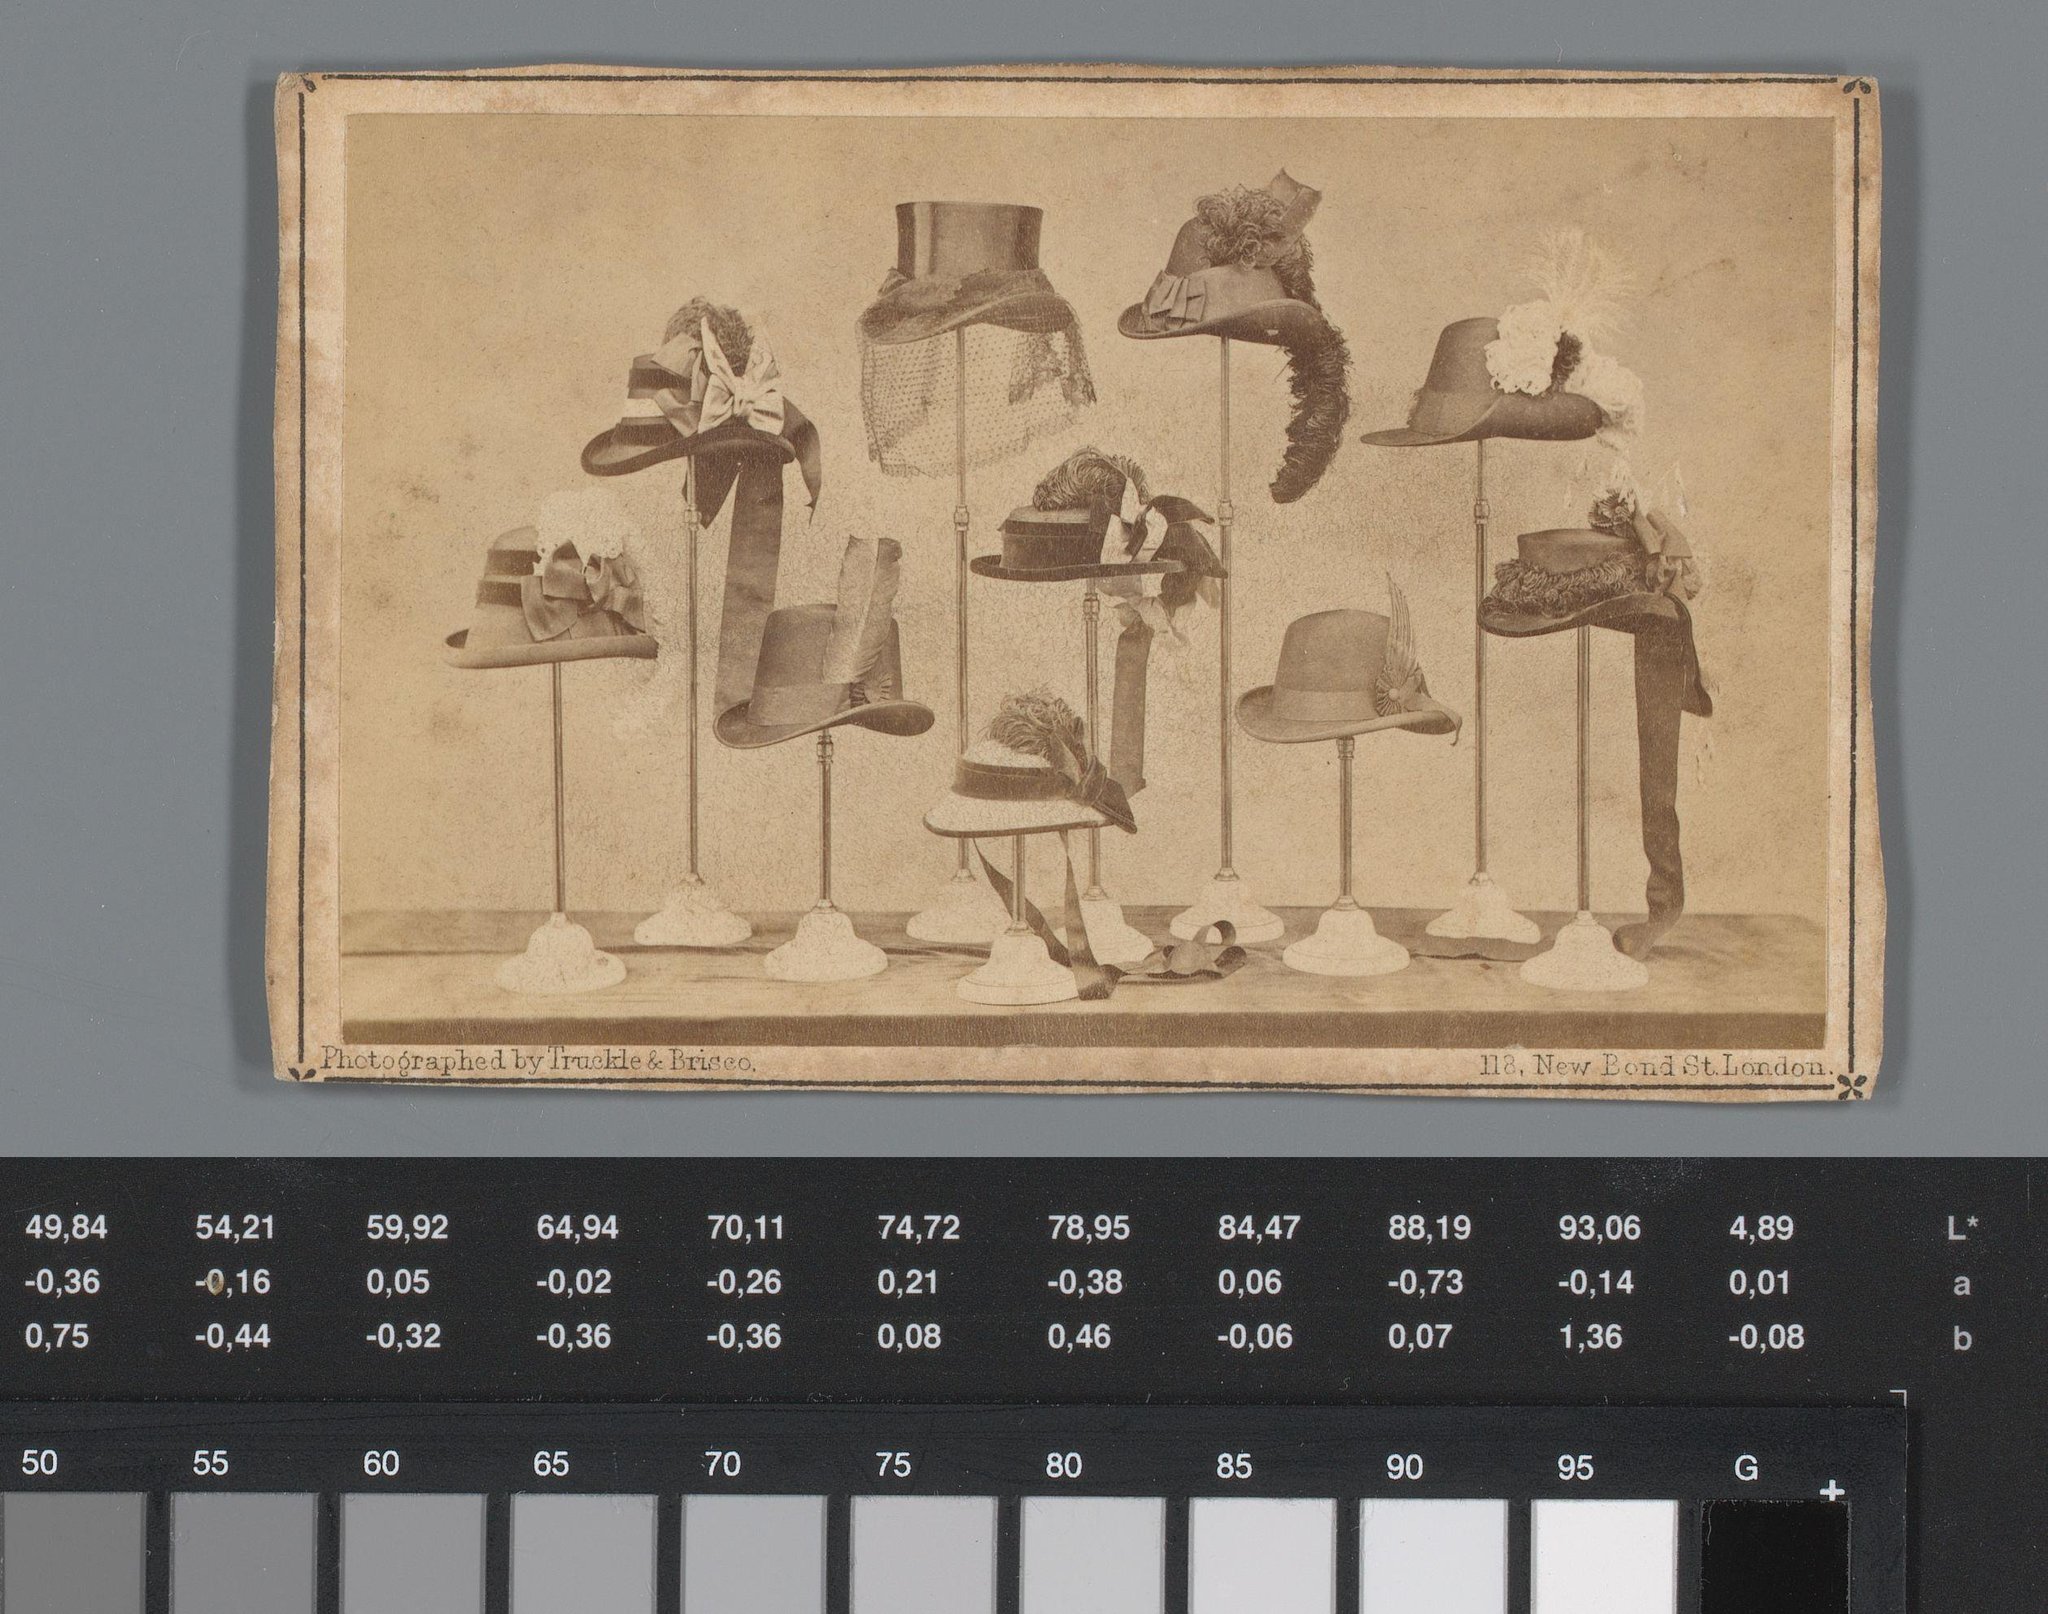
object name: carte de visite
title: Reclame voor een hoedenmakerij te Londen, met gezicht op tien verschillende modellen op standaard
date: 1873-1915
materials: cardboard, photographic support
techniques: albumen print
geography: london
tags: advertising, head-gear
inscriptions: inscription: ‘SAMPLE HATS SENT ON APPROVAL TO ANY PART OF THE UNITED KINGDOM’